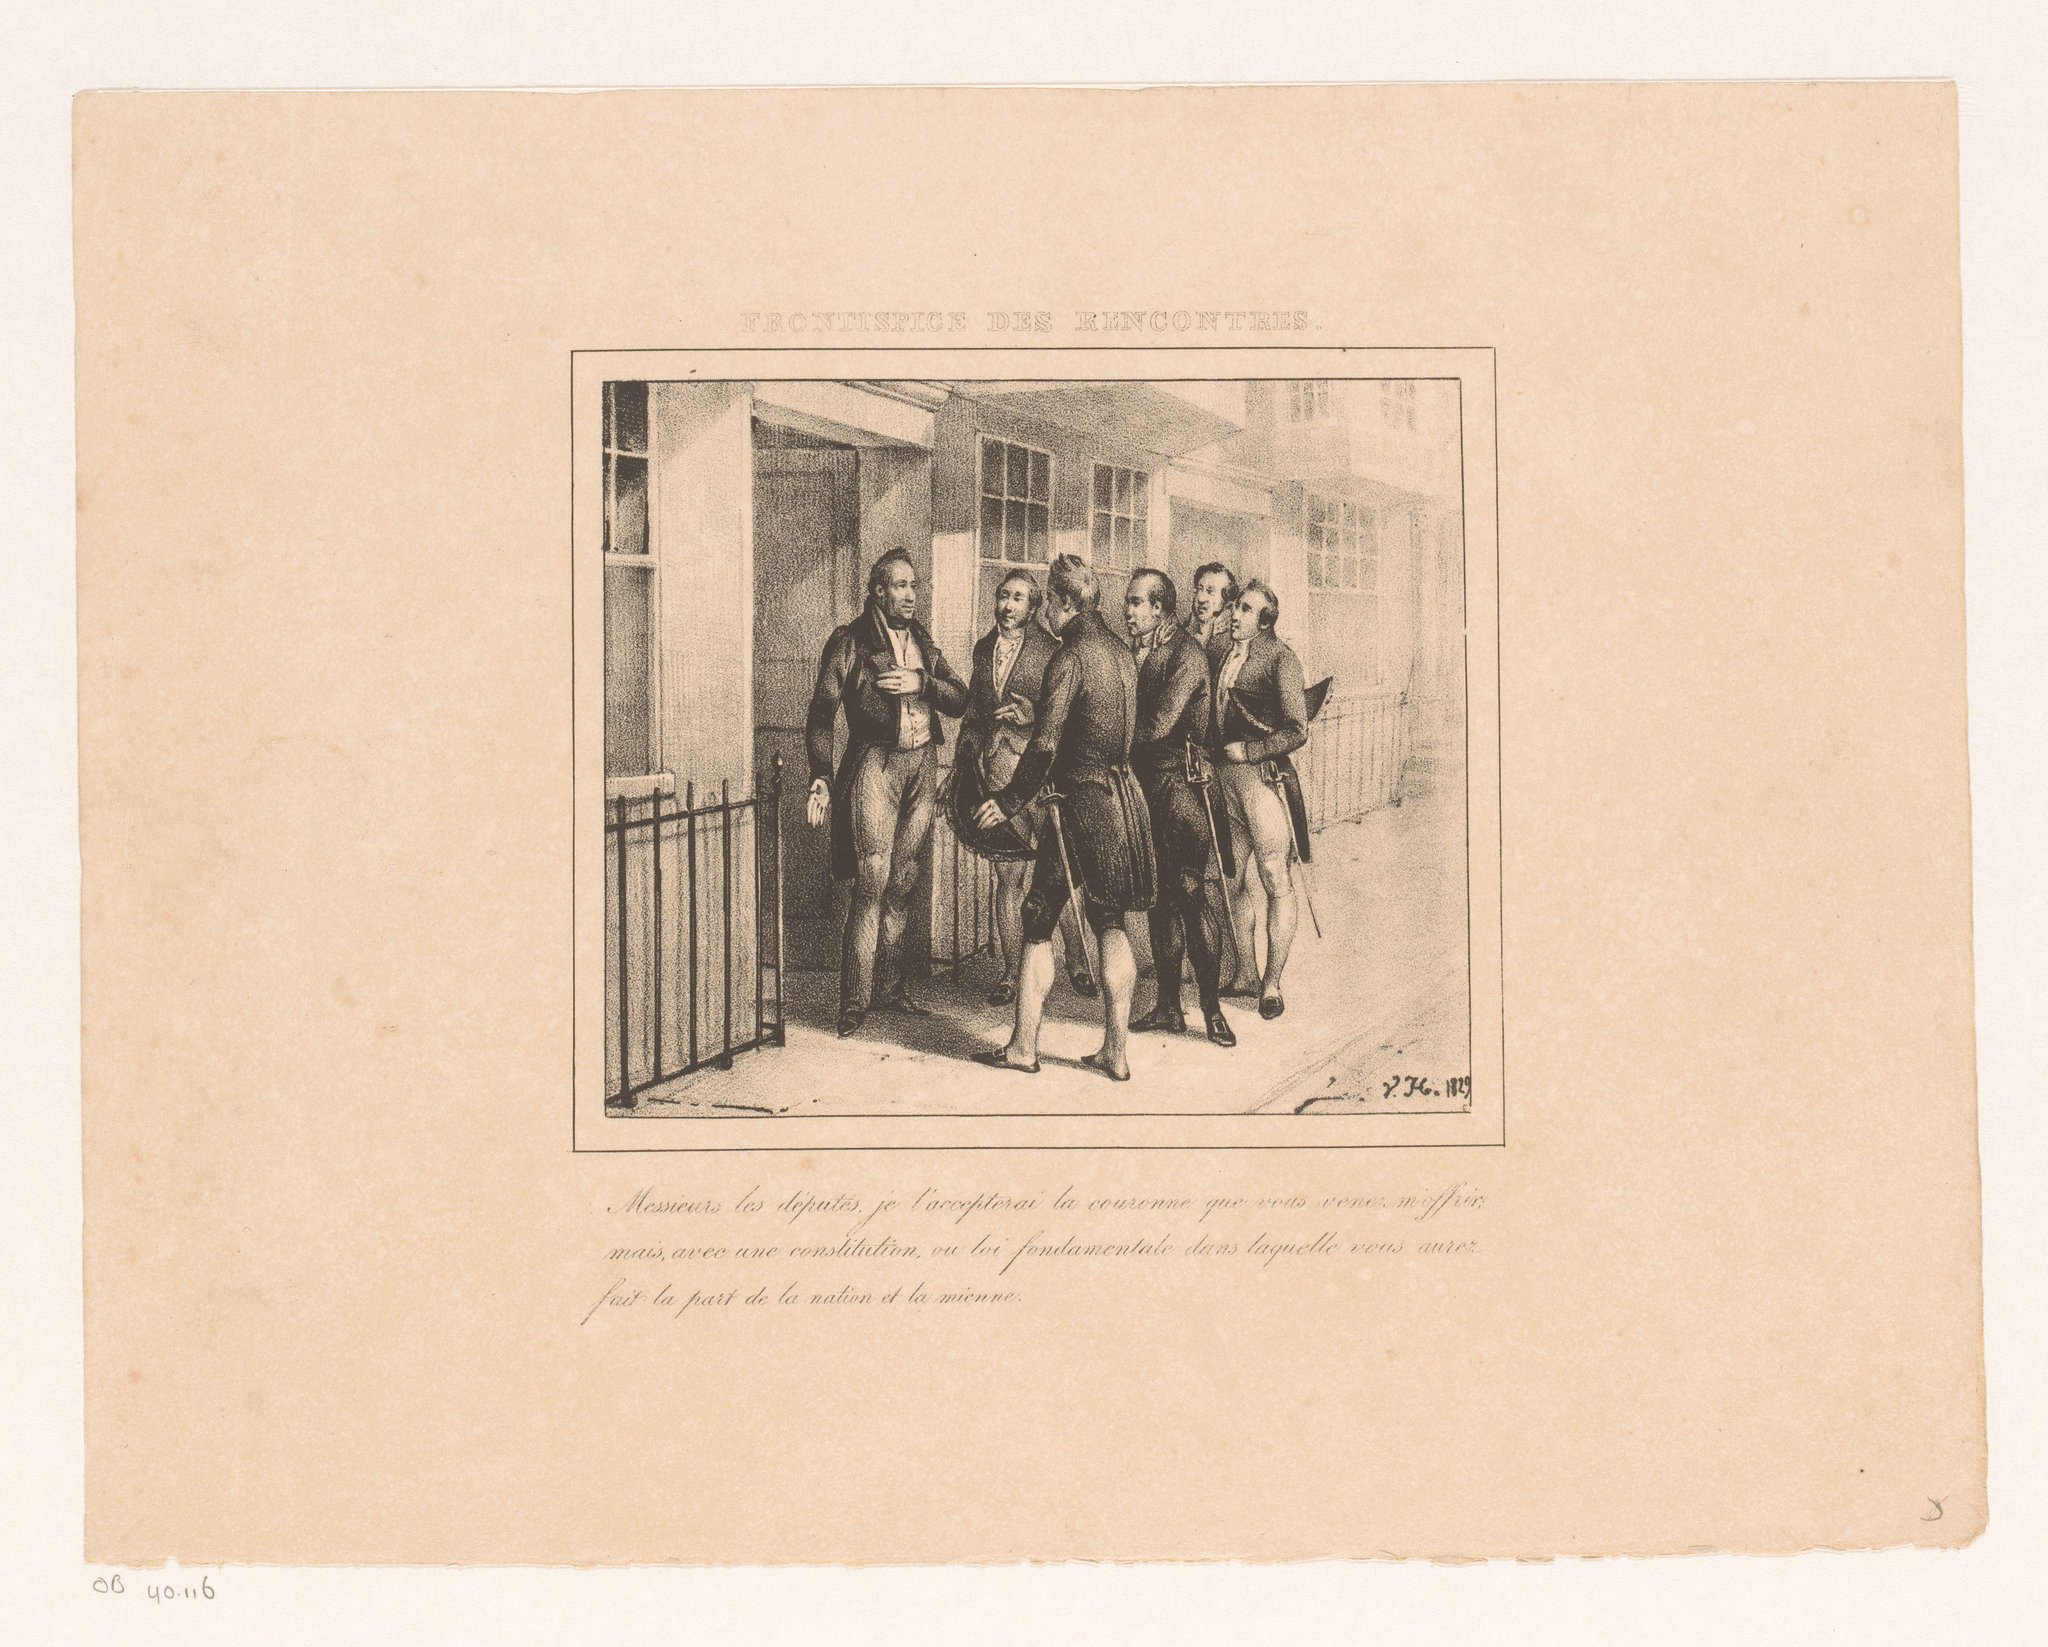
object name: print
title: Willem I accepteert op verzoek de Nederlandse kroon, 1829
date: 1829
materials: paper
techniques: lithograph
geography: brussels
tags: the hague, berlin, william i of the netherlands, adult man (+ six persons), street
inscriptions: collector's mark: Lugt 2228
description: De vorst staande in de deuropening tegenover een groep van vijf mannen zegt de Nederlandse kroon te willen accepteren, maar alleen als er ook een grondwet is. Met drieregelig onderschrift.